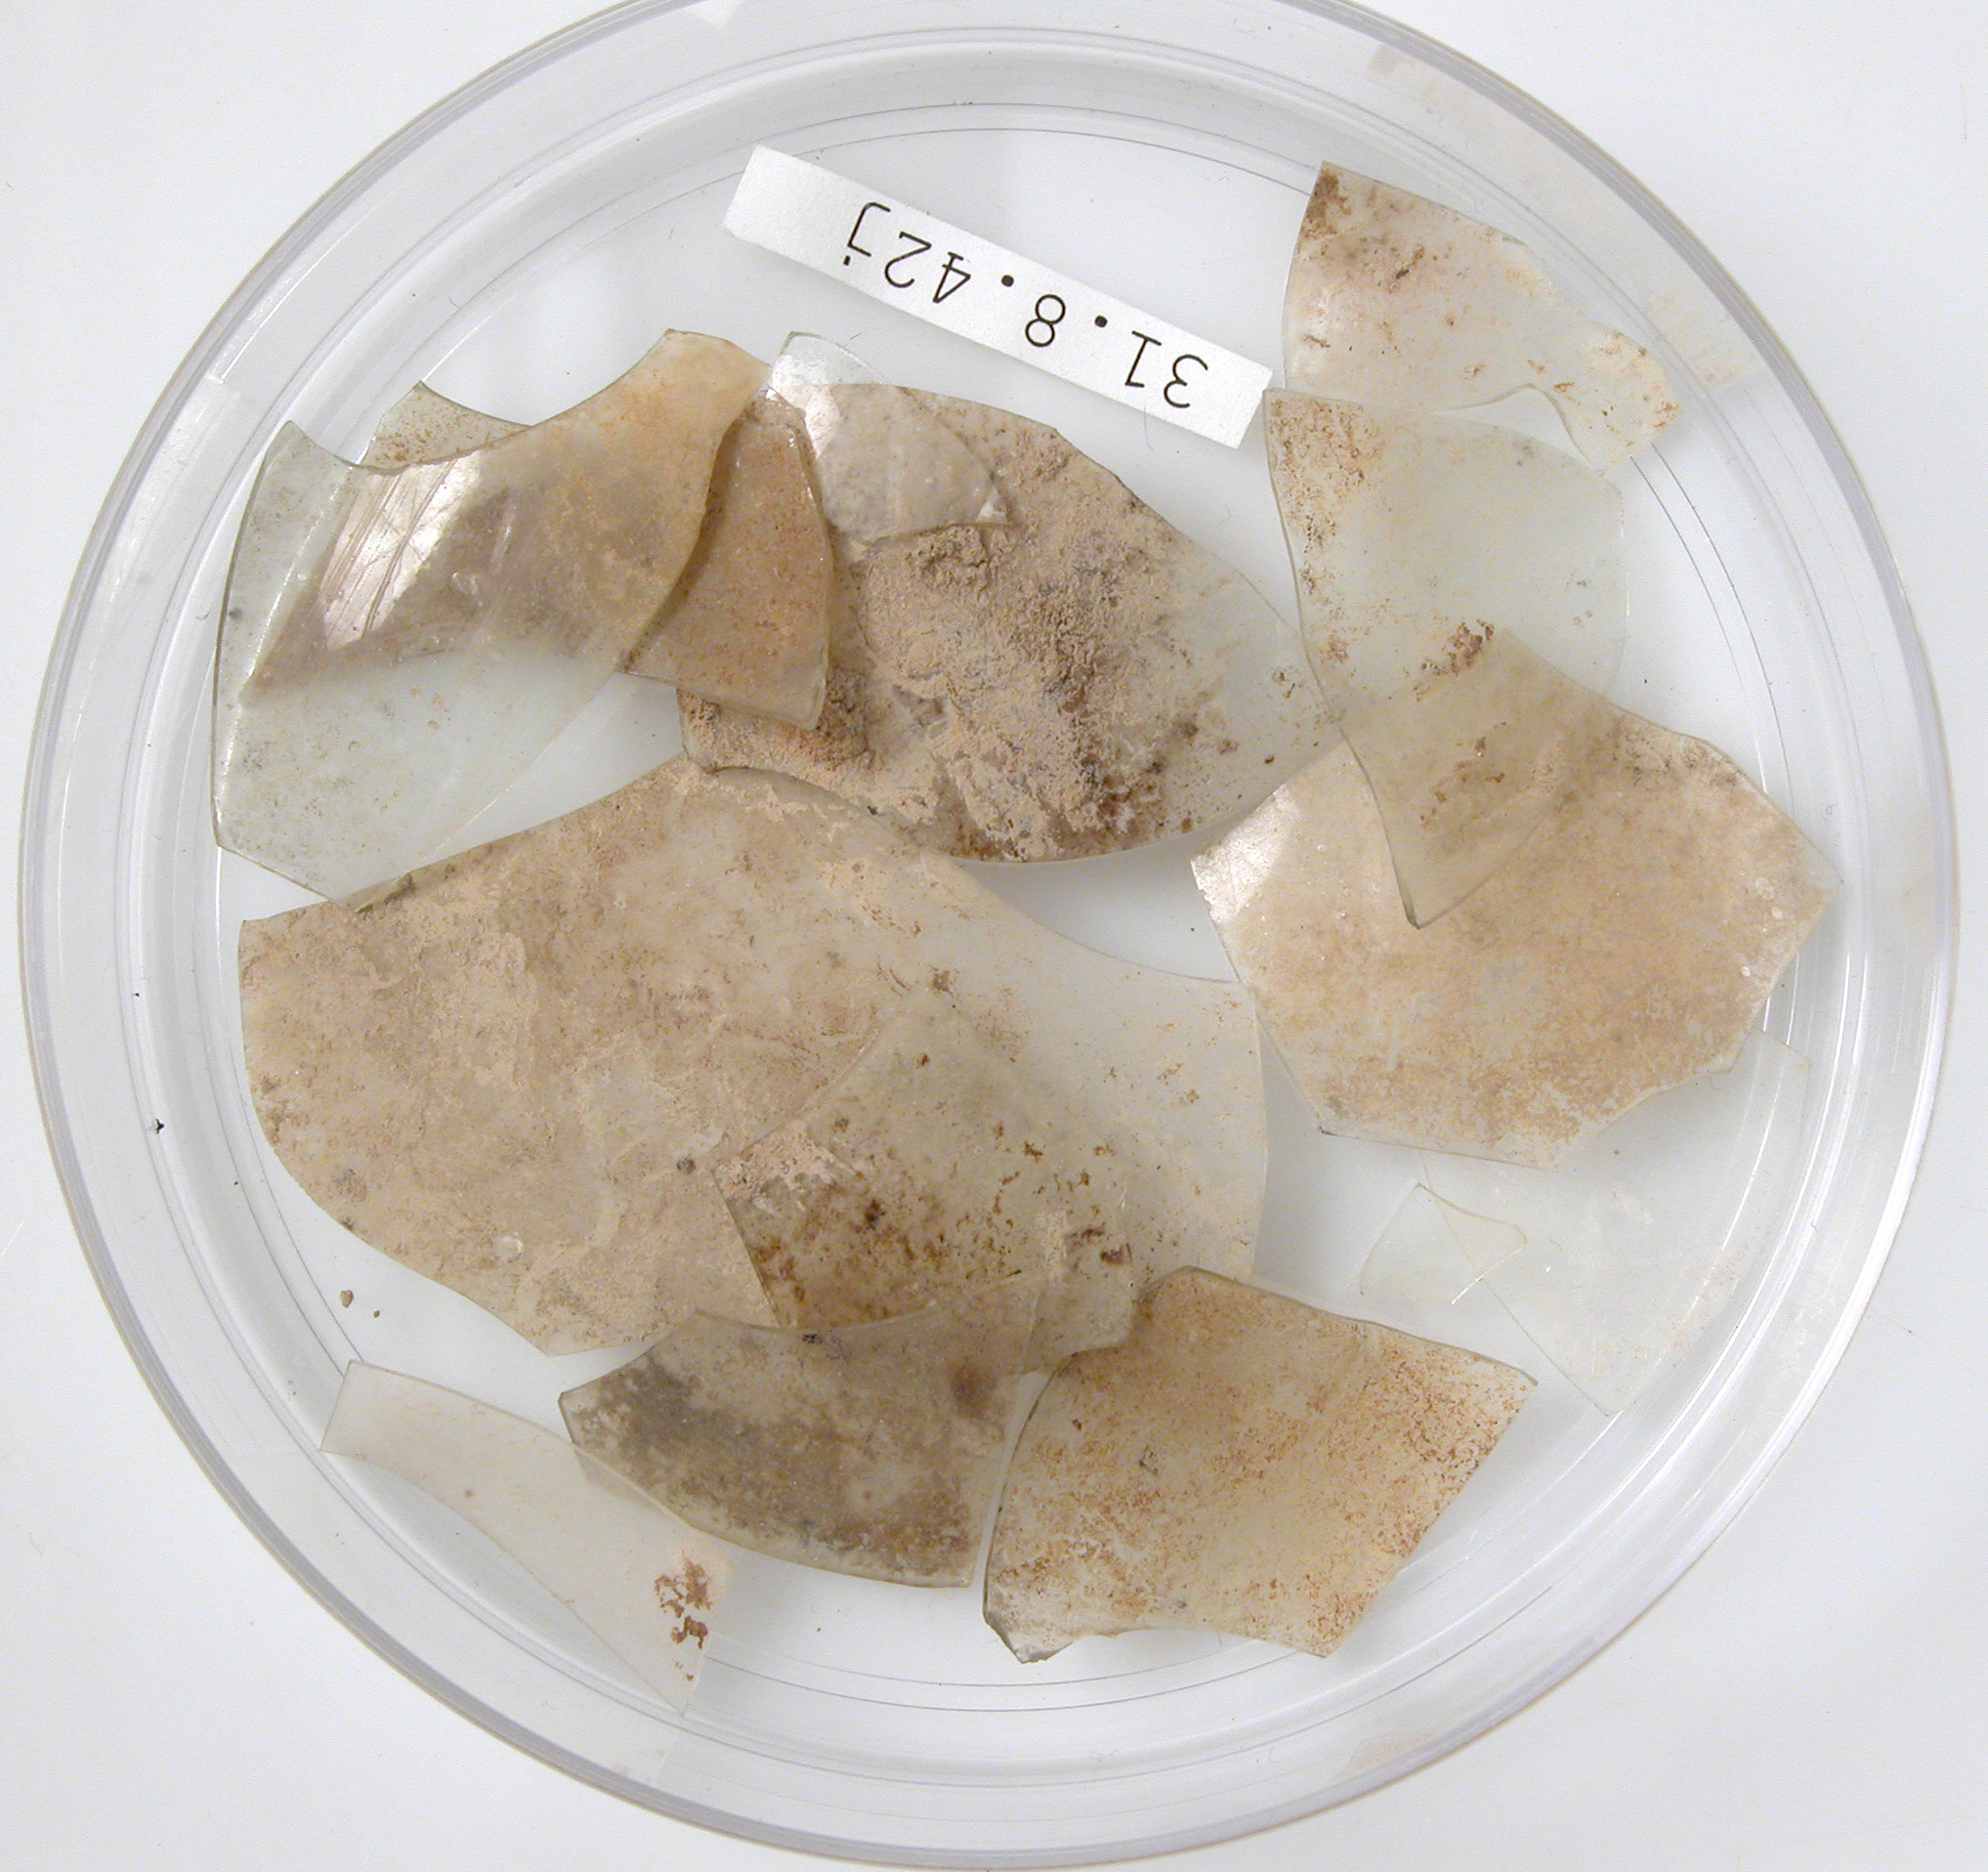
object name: fragment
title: Glass Fragments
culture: coptic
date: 301-400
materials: glass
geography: egypt